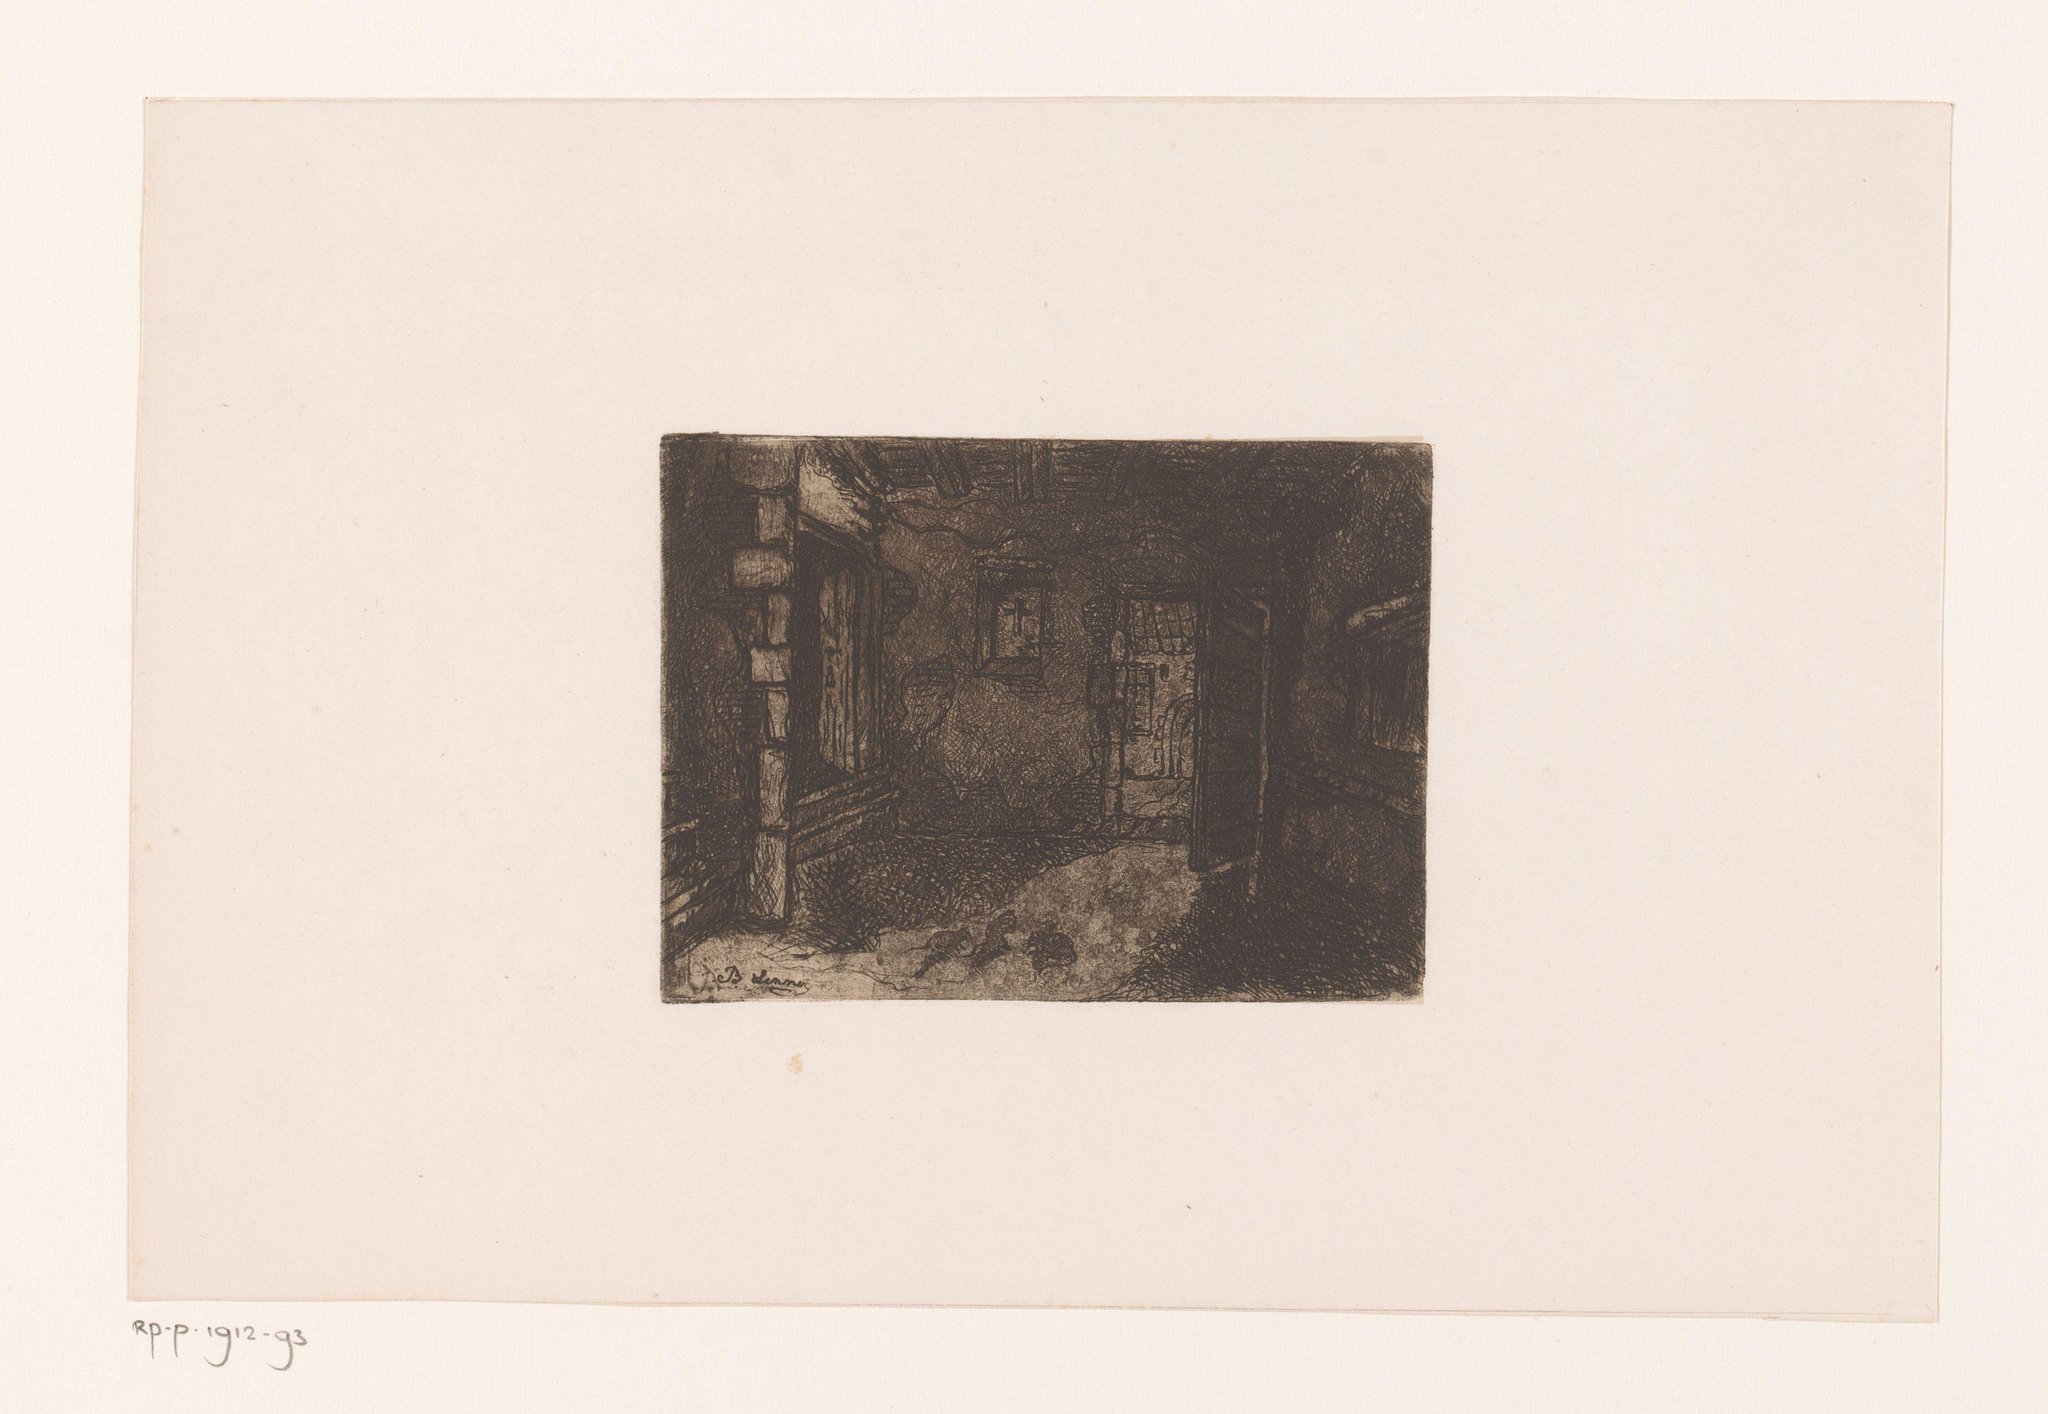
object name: print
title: Drie muizen in een interieur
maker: ben linnig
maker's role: print maker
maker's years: 1860-1929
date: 1870-1912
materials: paper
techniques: drypoint, etching, intaglio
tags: rodents: mouse, interior of the house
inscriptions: collector's mark: Lugt 2228